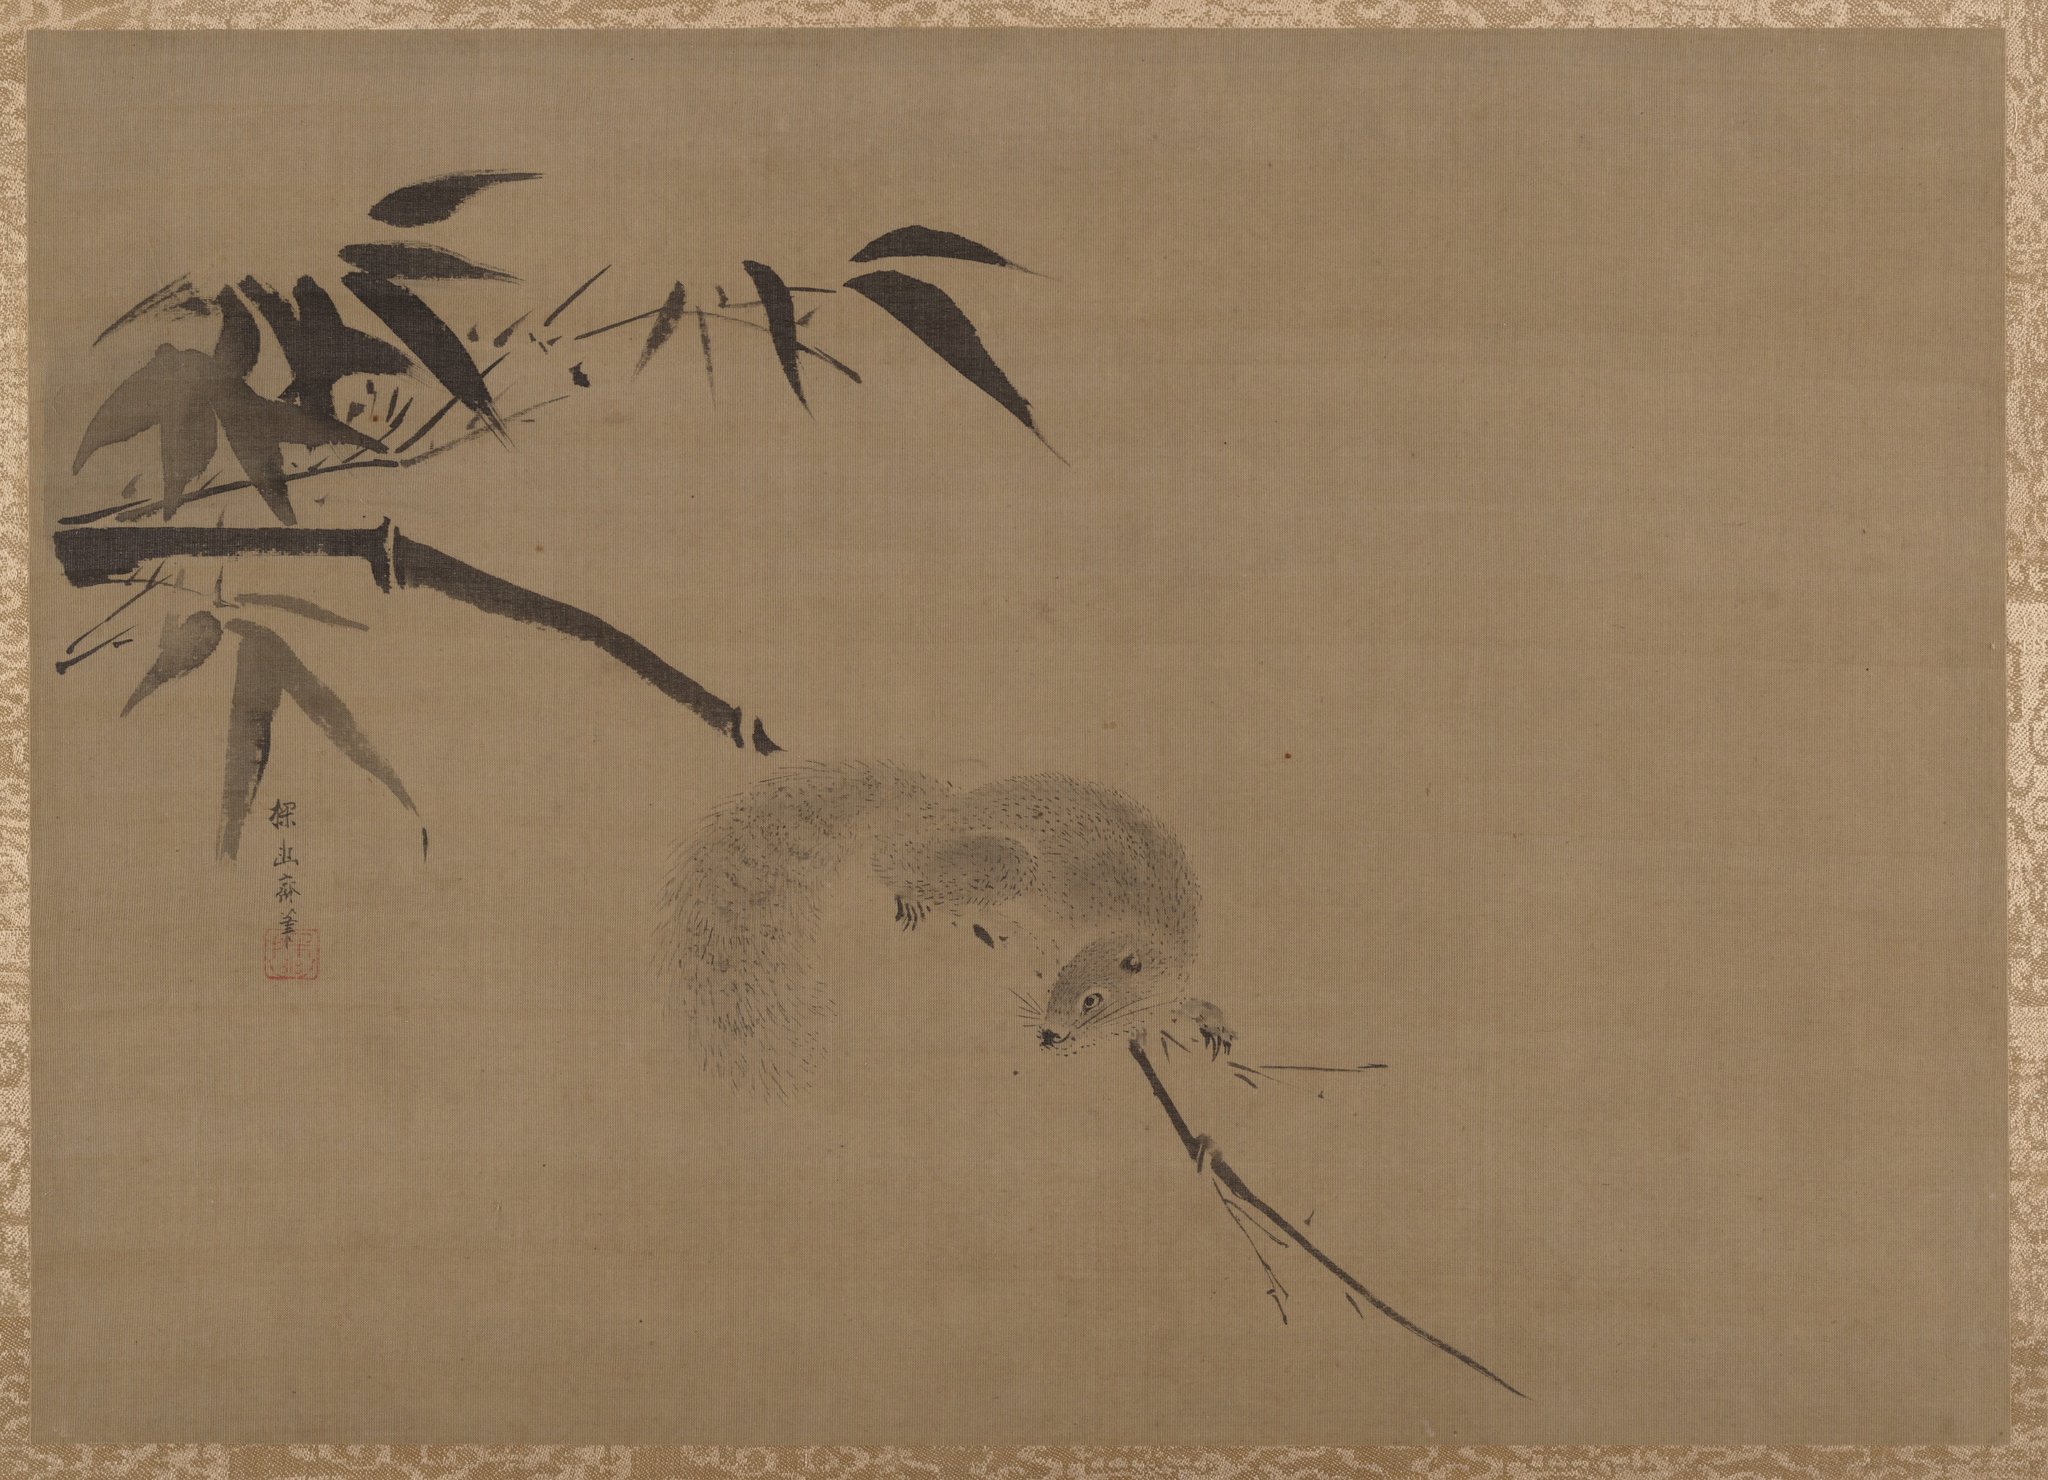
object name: album leaf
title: Squirrel on Bamboo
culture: japanese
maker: kano tan'yū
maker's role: artist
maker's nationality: japanese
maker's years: 1602-1674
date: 1650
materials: ink, silk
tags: squirrels,bamboo